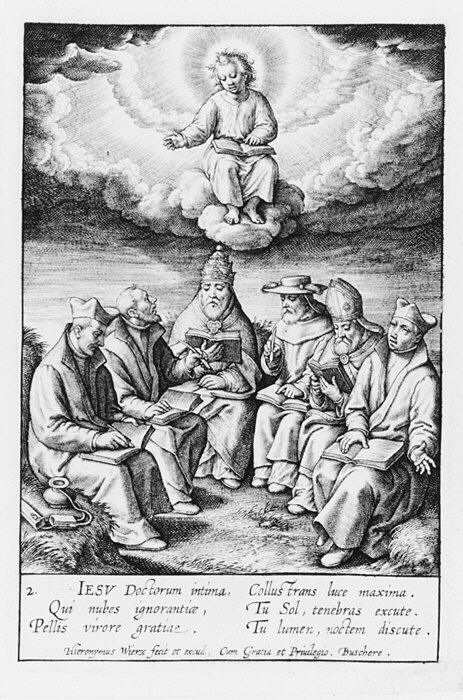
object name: print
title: The child Jesus above a group of ecclesiastics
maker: hieronymus wierix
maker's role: artist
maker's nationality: netherlandish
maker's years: 1553-1619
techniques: engraving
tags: jesus,saints